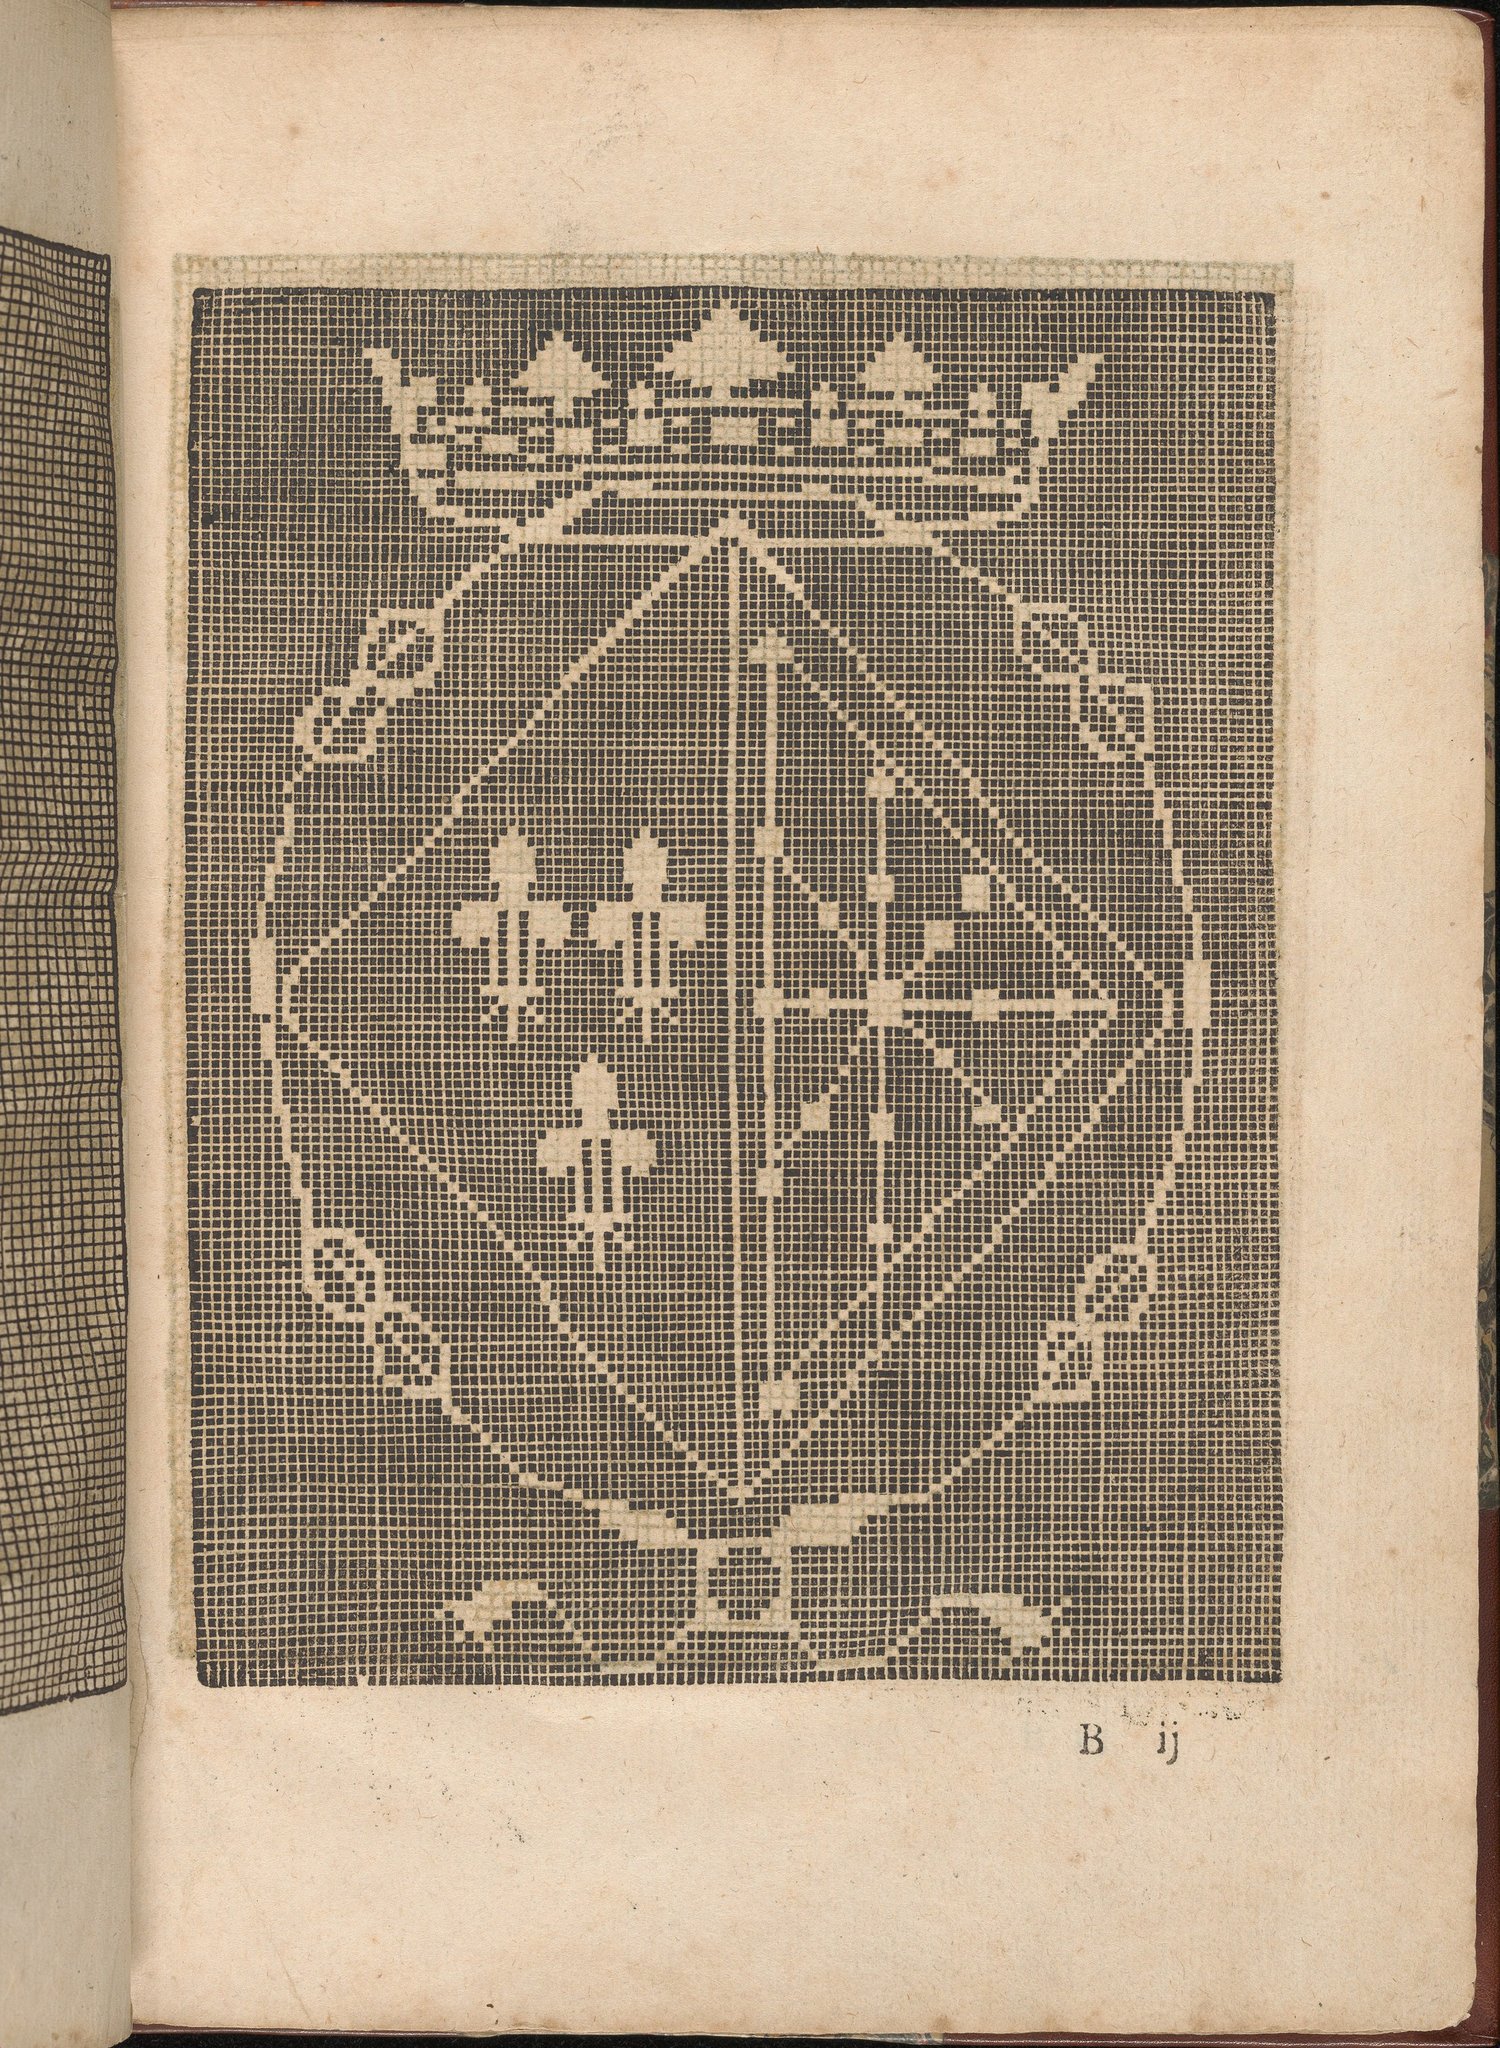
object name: book print ornament architecture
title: Les Secondes Oeuvres, et Subtiles Inventions De Lingerie du Seigneur Federic de Vinciolo Venitien, page 6 (recto)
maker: federico de vinciolo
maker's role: designer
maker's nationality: italian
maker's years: 1582-1599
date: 1603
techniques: woodcut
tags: ornament